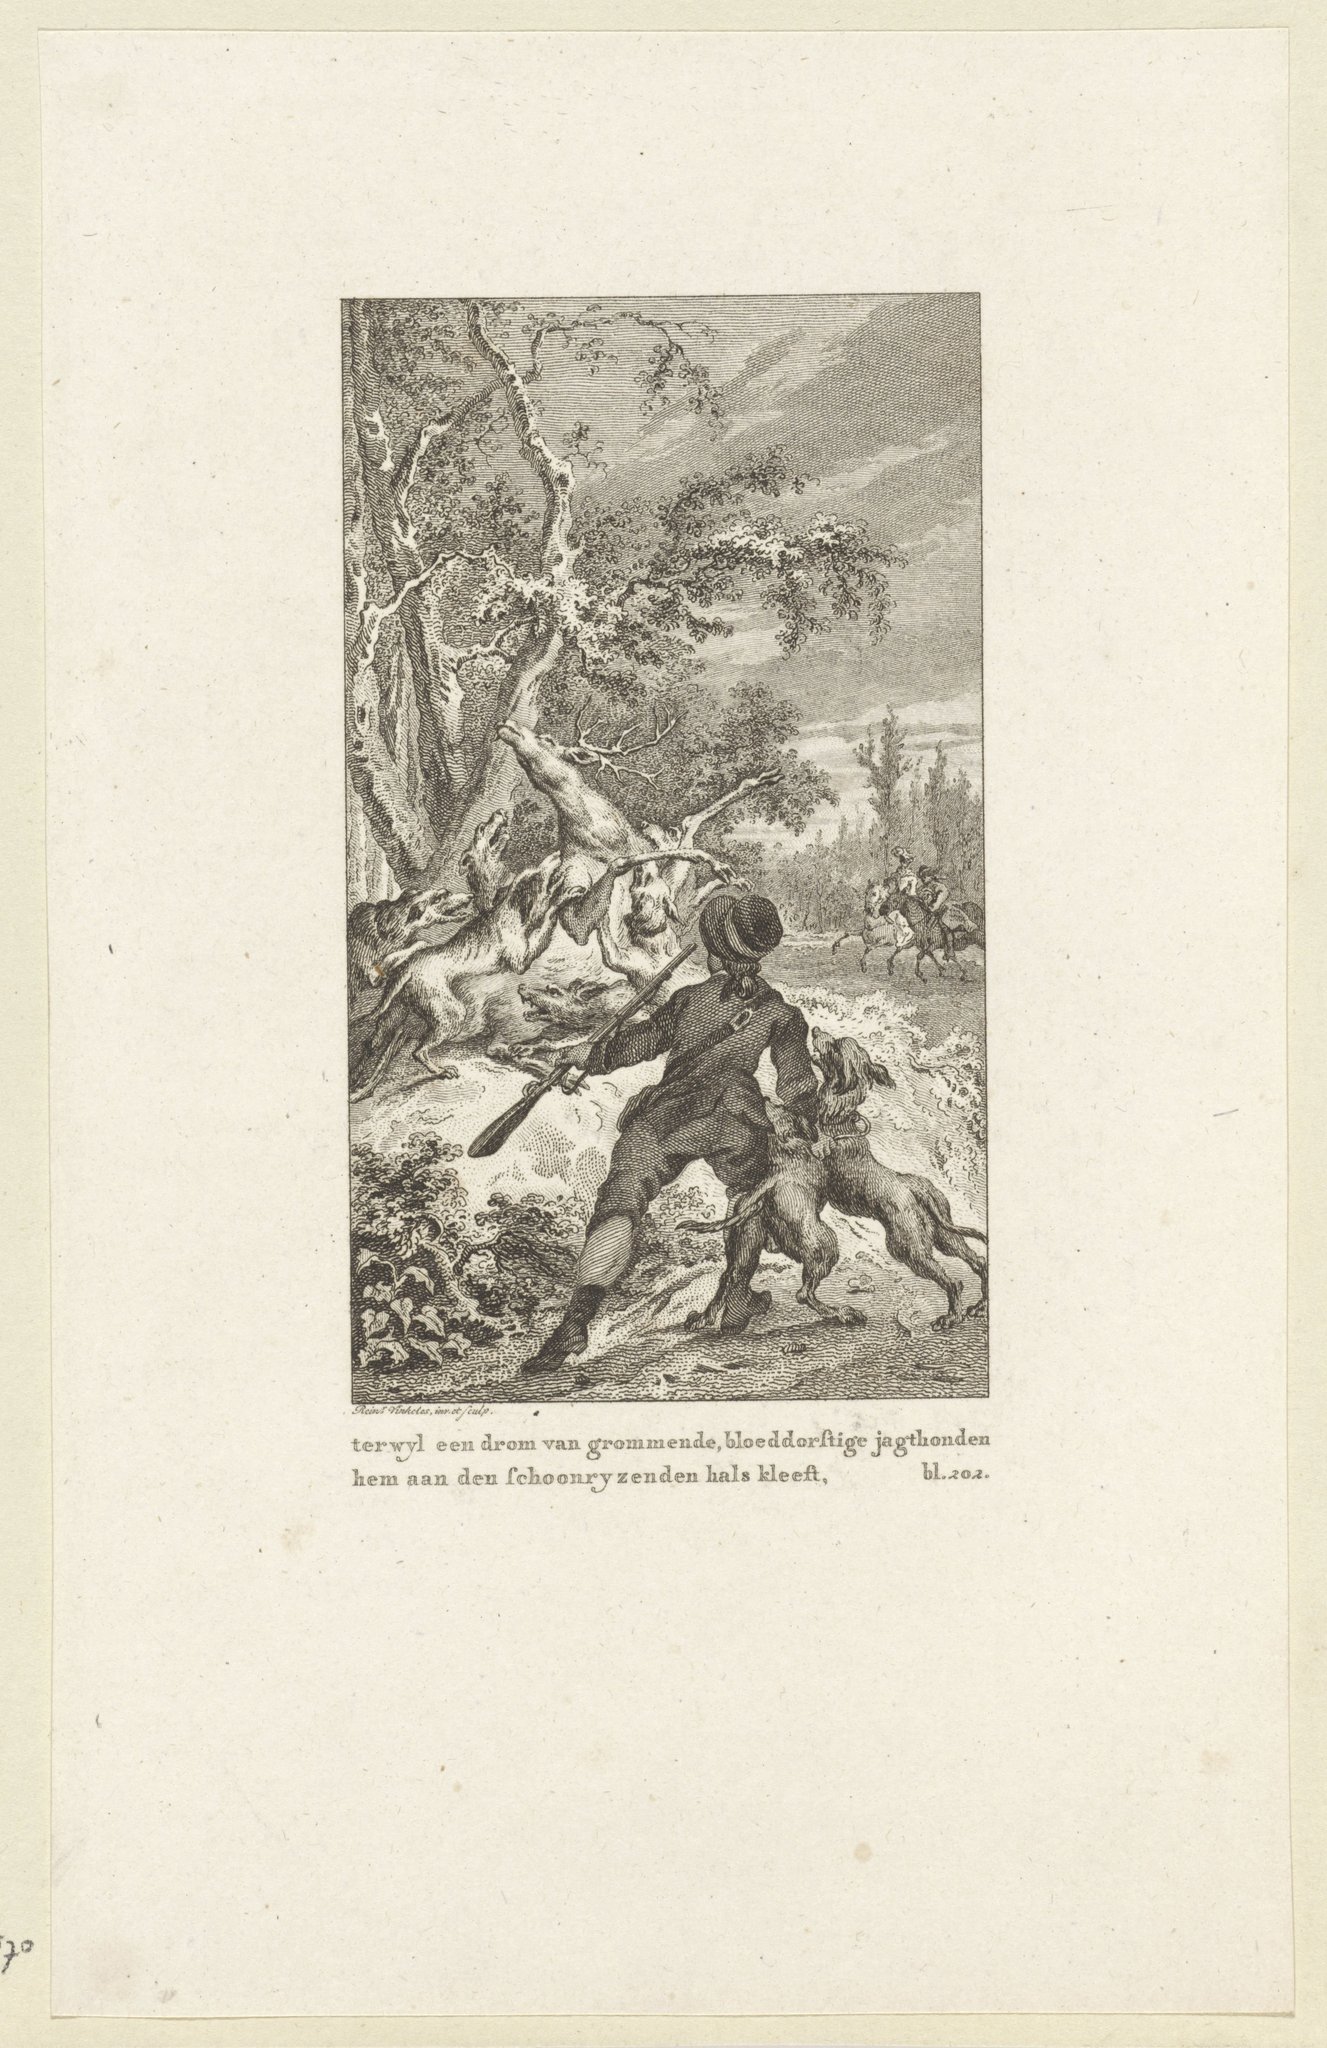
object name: print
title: Honden jagen een hert op en vallen het aan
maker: reinier vinkeles (i)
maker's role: draughtsman, print maker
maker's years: 1741-1816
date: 1751-1816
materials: paper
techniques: engraving, etching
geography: amsterdam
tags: hoofed animals: deer, hunting dogs, hunter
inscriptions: collector's mark: Lugt 240